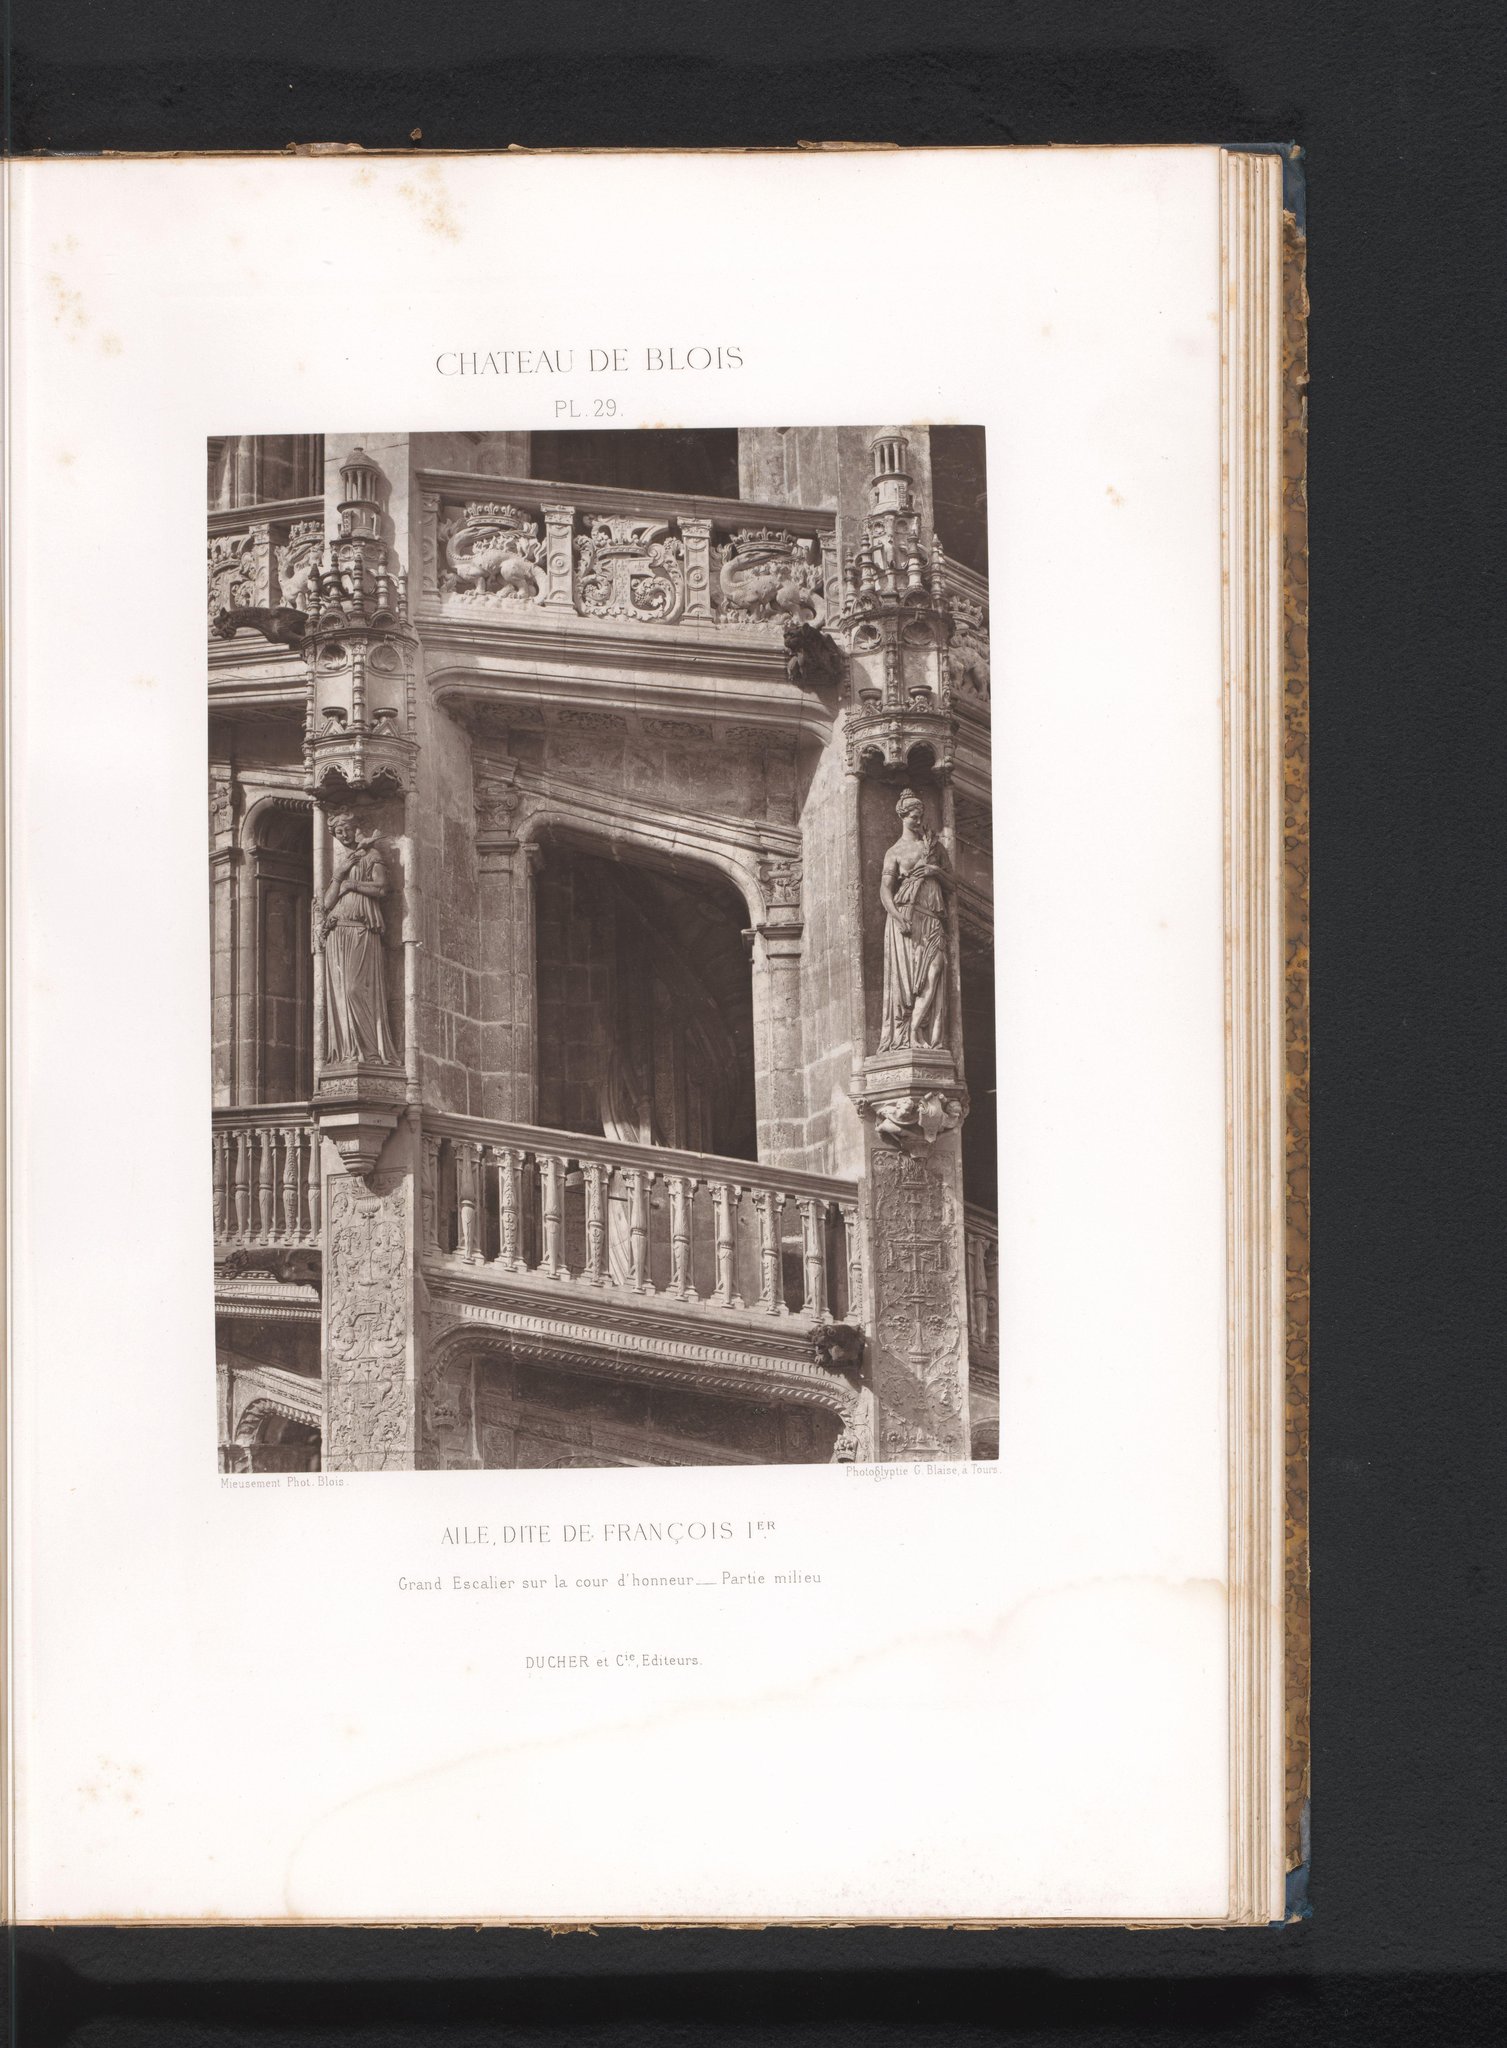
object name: photomechanical print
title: Gezicht op het trappenhuis van de Frans I vleugel van het Kasteel van Blois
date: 1870-1875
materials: paper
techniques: woodburytype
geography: tours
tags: stairwell, castle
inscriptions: number: ‘PL. 29.’